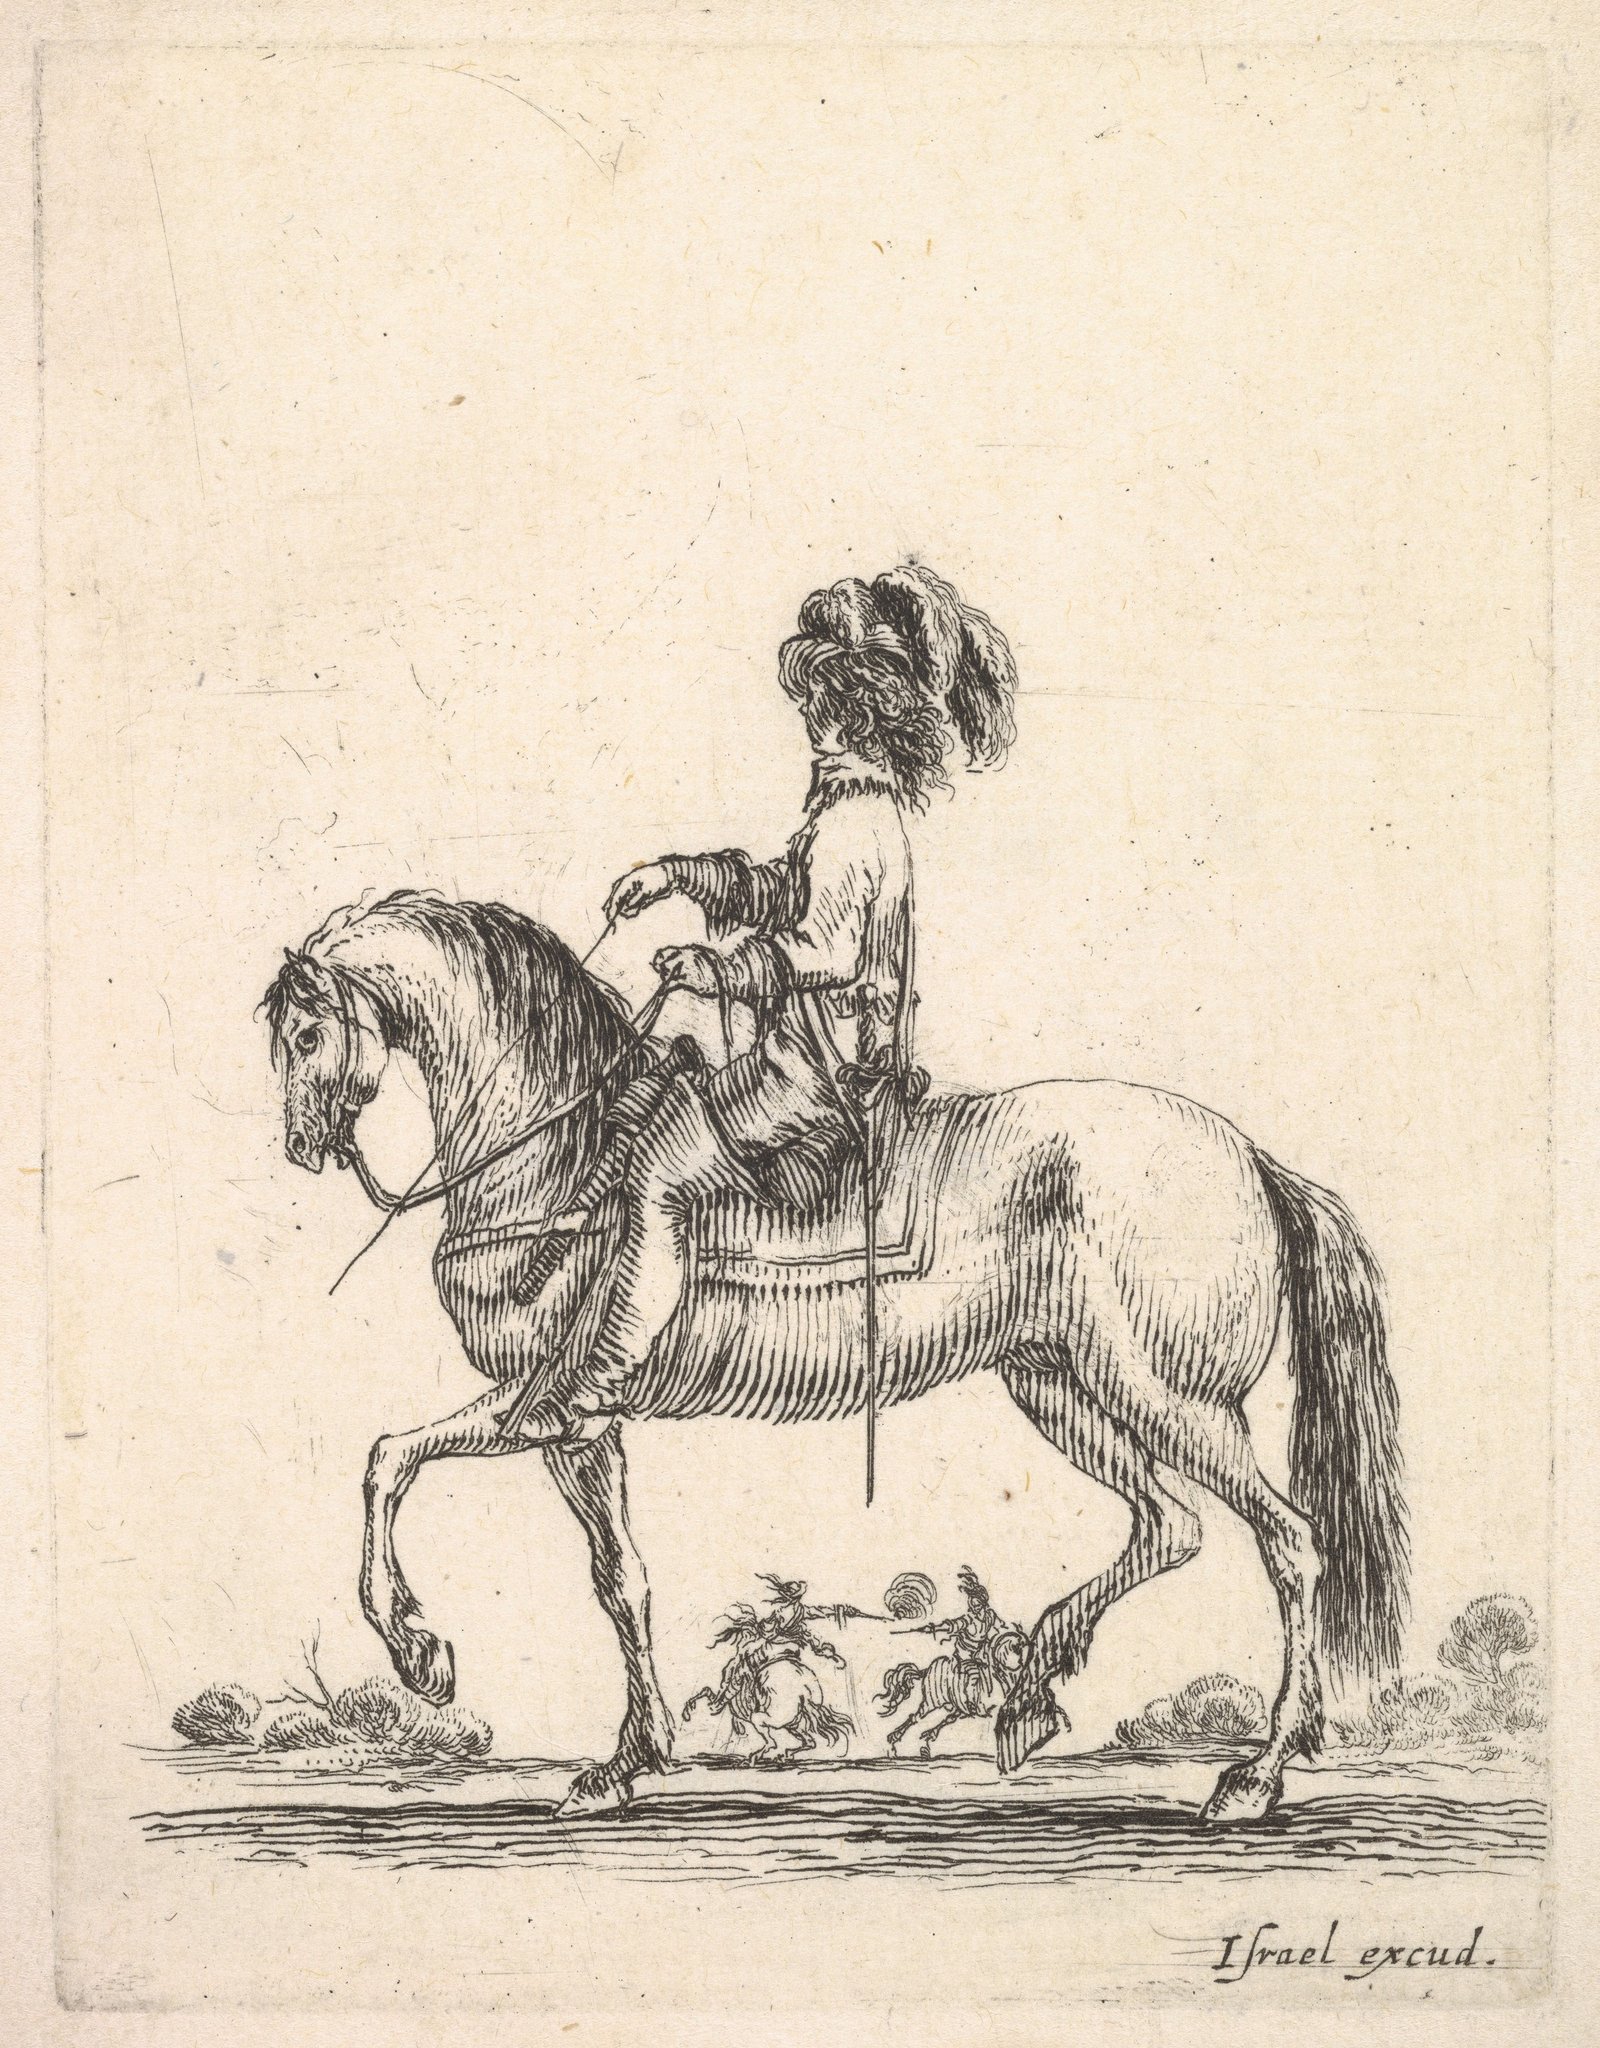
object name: print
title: A horseman in profile walking to the left, two horsemen duel with pistols in the background, from "Various cavalry exercises" (Diverses exercices de cavalerie)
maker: stefano della bella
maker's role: artist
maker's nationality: italian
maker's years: 1610-1664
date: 1642-1645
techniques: etching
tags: men,profiles,horses